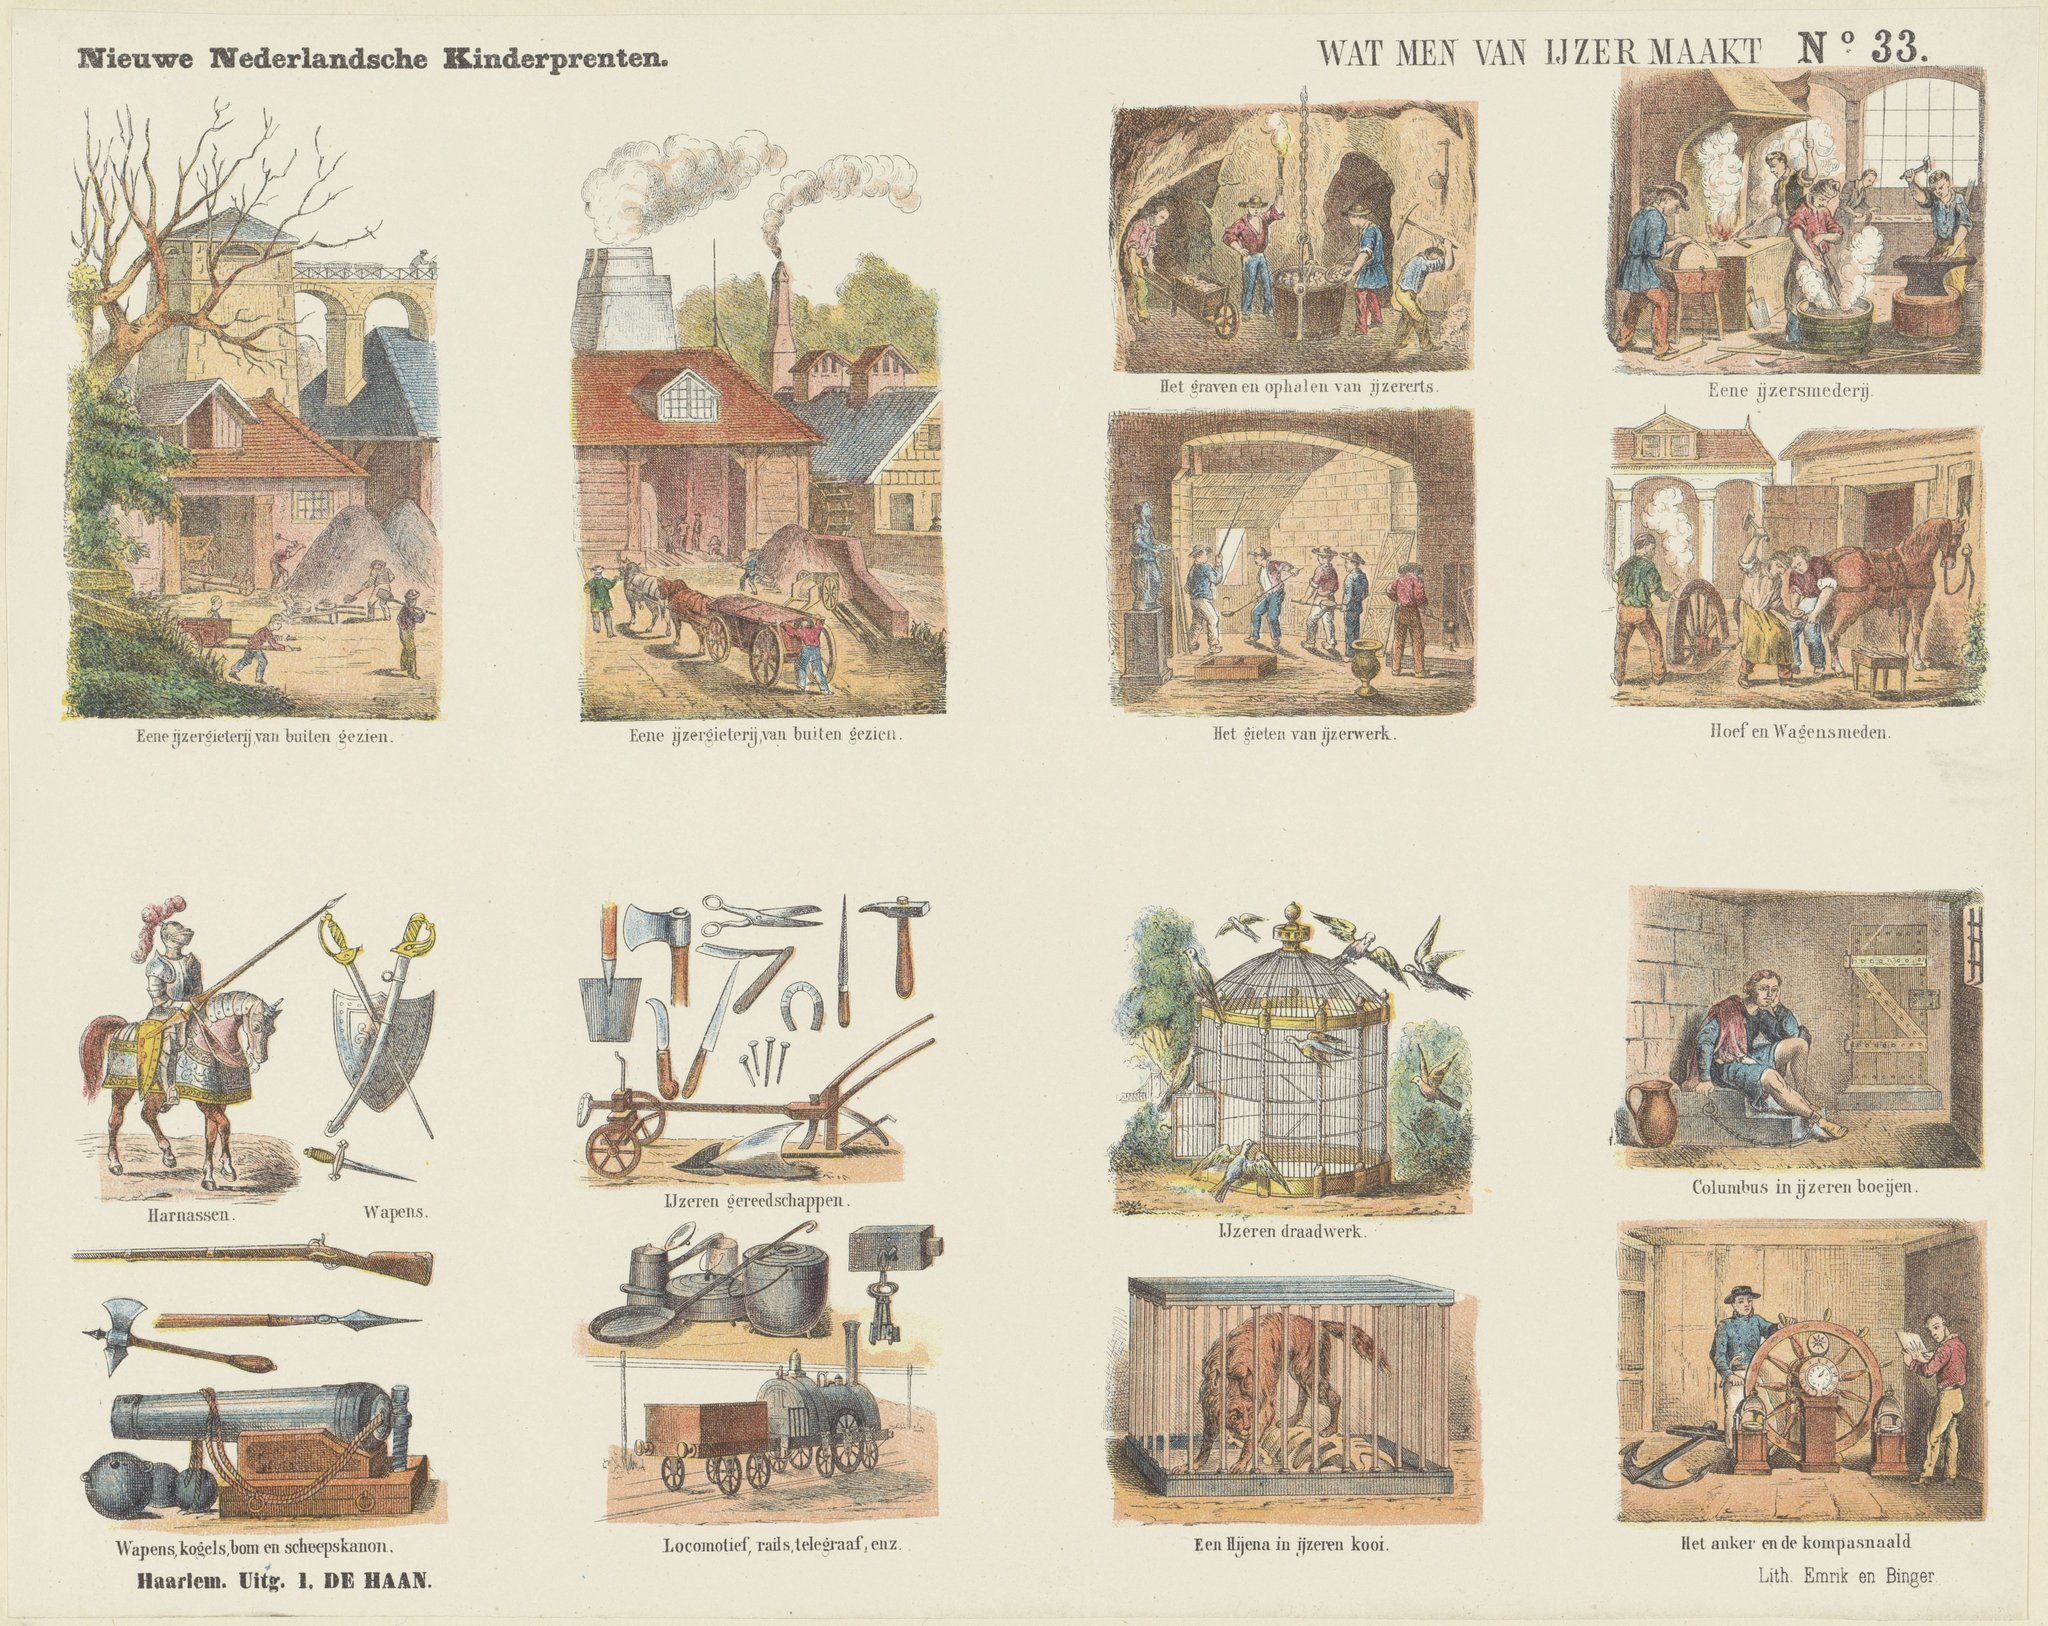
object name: print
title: Nieuwe Nederlandsche kinderprenten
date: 1875-1903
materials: paper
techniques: lithograph, letterpress printing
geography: haarlem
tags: craft-production, skilled handiwork, armour, weapons, smith, blacksmith, crafts and industries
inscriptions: collector's mark: Lugt 2760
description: Blad met 15 voorstellingen van ambachtslieden die producten van ijzer maken en de uiteindelijke producten (harnassen, wapens en gereedschappen). Onder elke afbeelding een onderschrift. Genummerd rechtsboven: No. 33.